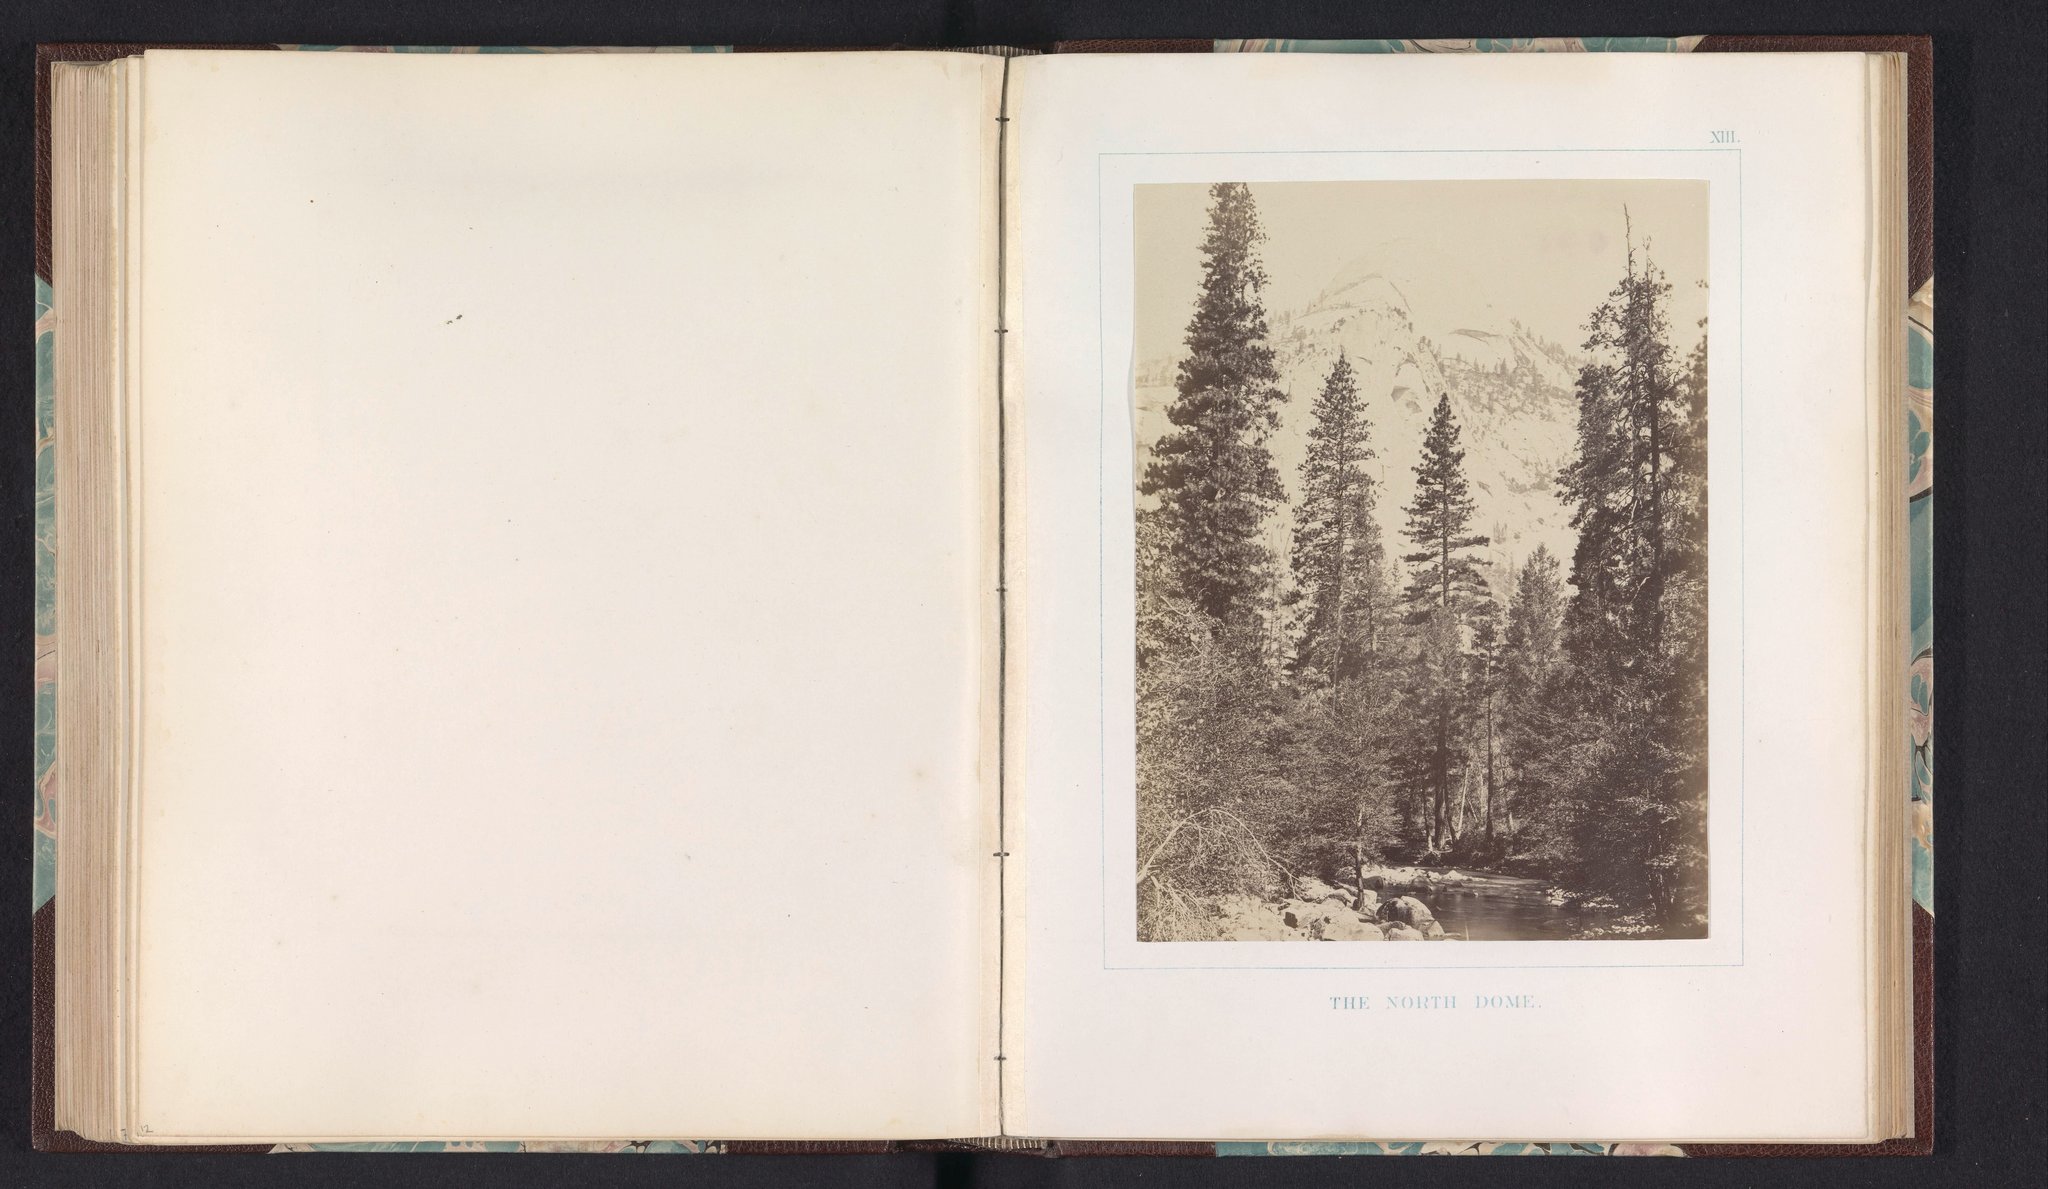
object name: page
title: The North Dome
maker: carleton e. watkins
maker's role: fotograaf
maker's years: 1829-1916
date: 1860-1868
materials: photographic support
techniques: albumen print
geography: yosemite valley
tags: dale, valley, rock-formations, mountains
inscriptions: number: ‘XIII.’